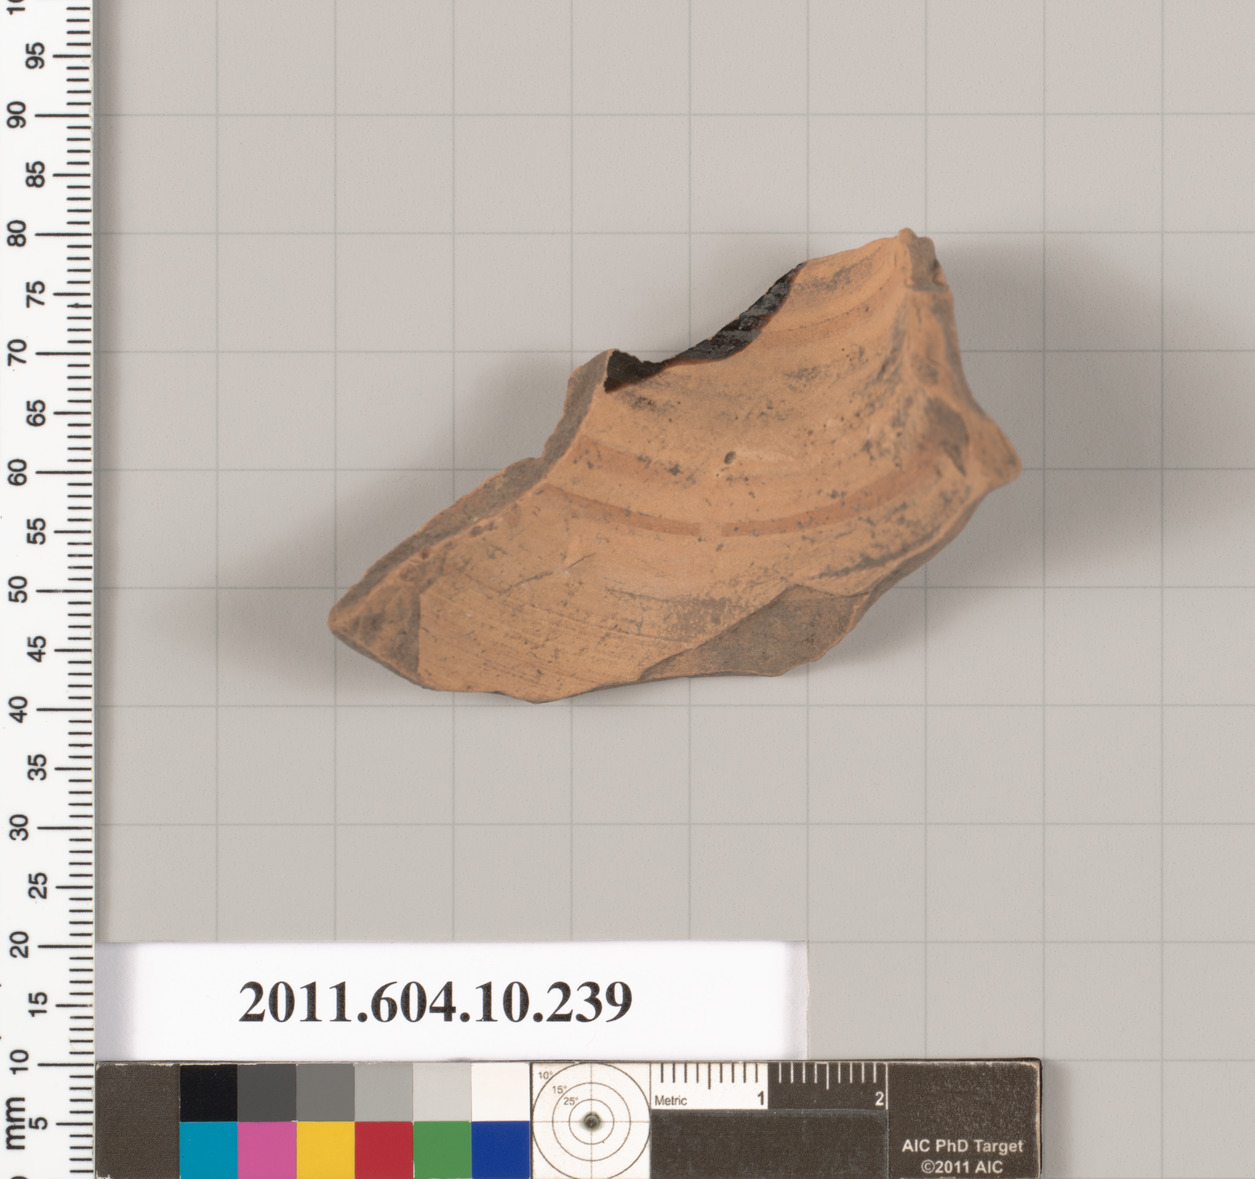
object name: oinochoe fragment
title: Terracotta fragment of an oinochoe (jug)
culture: etruscan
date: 601-700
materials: terracotta